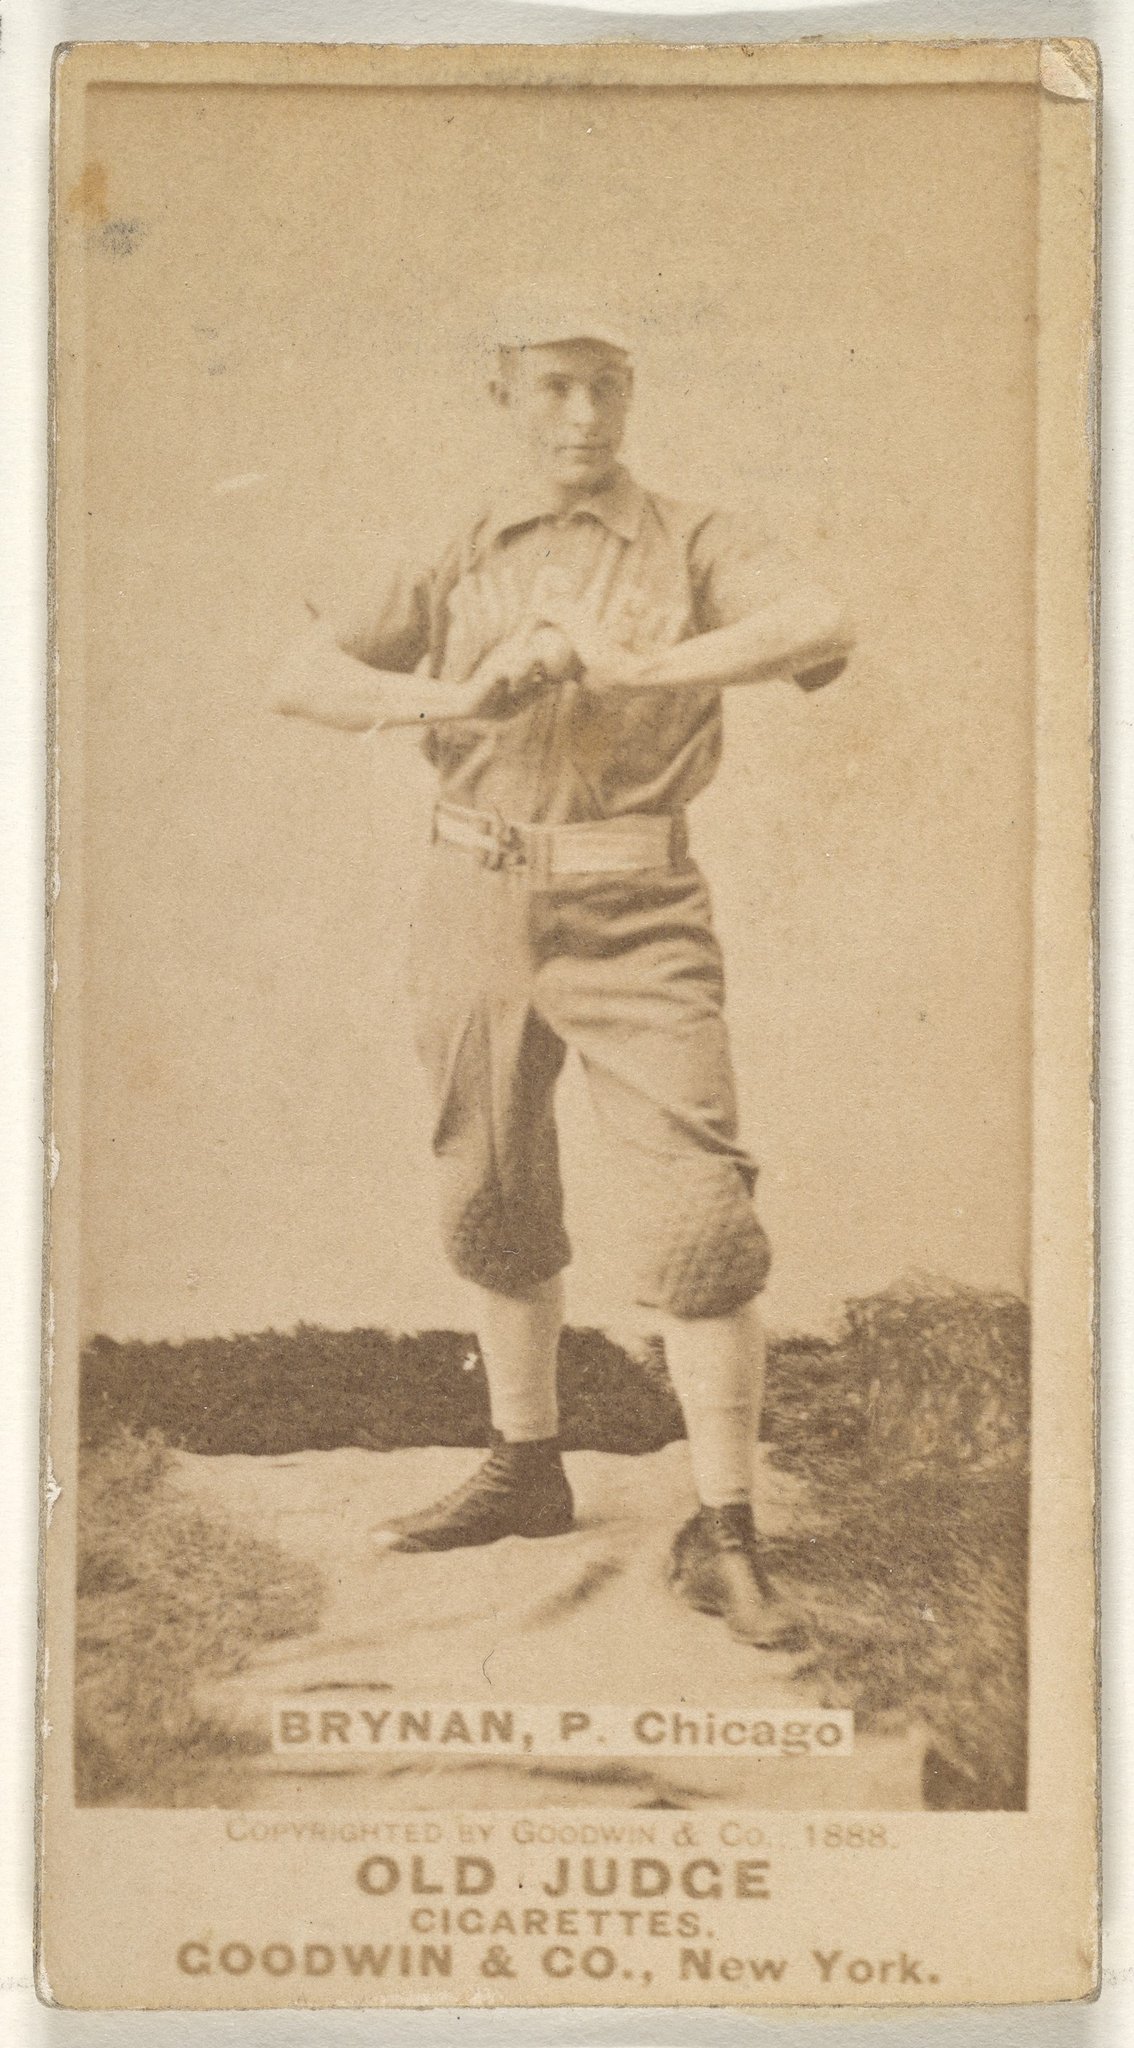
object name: baseball card, photograph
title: Brynan, Pitcher, Chicago, from the Old Judge series (N172) for Old Judge Cigarettes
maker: goodwin & company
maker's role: publisher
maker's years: 1850-1950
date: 1888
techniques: albumen silver print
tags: men,portraits,baseball,athletes